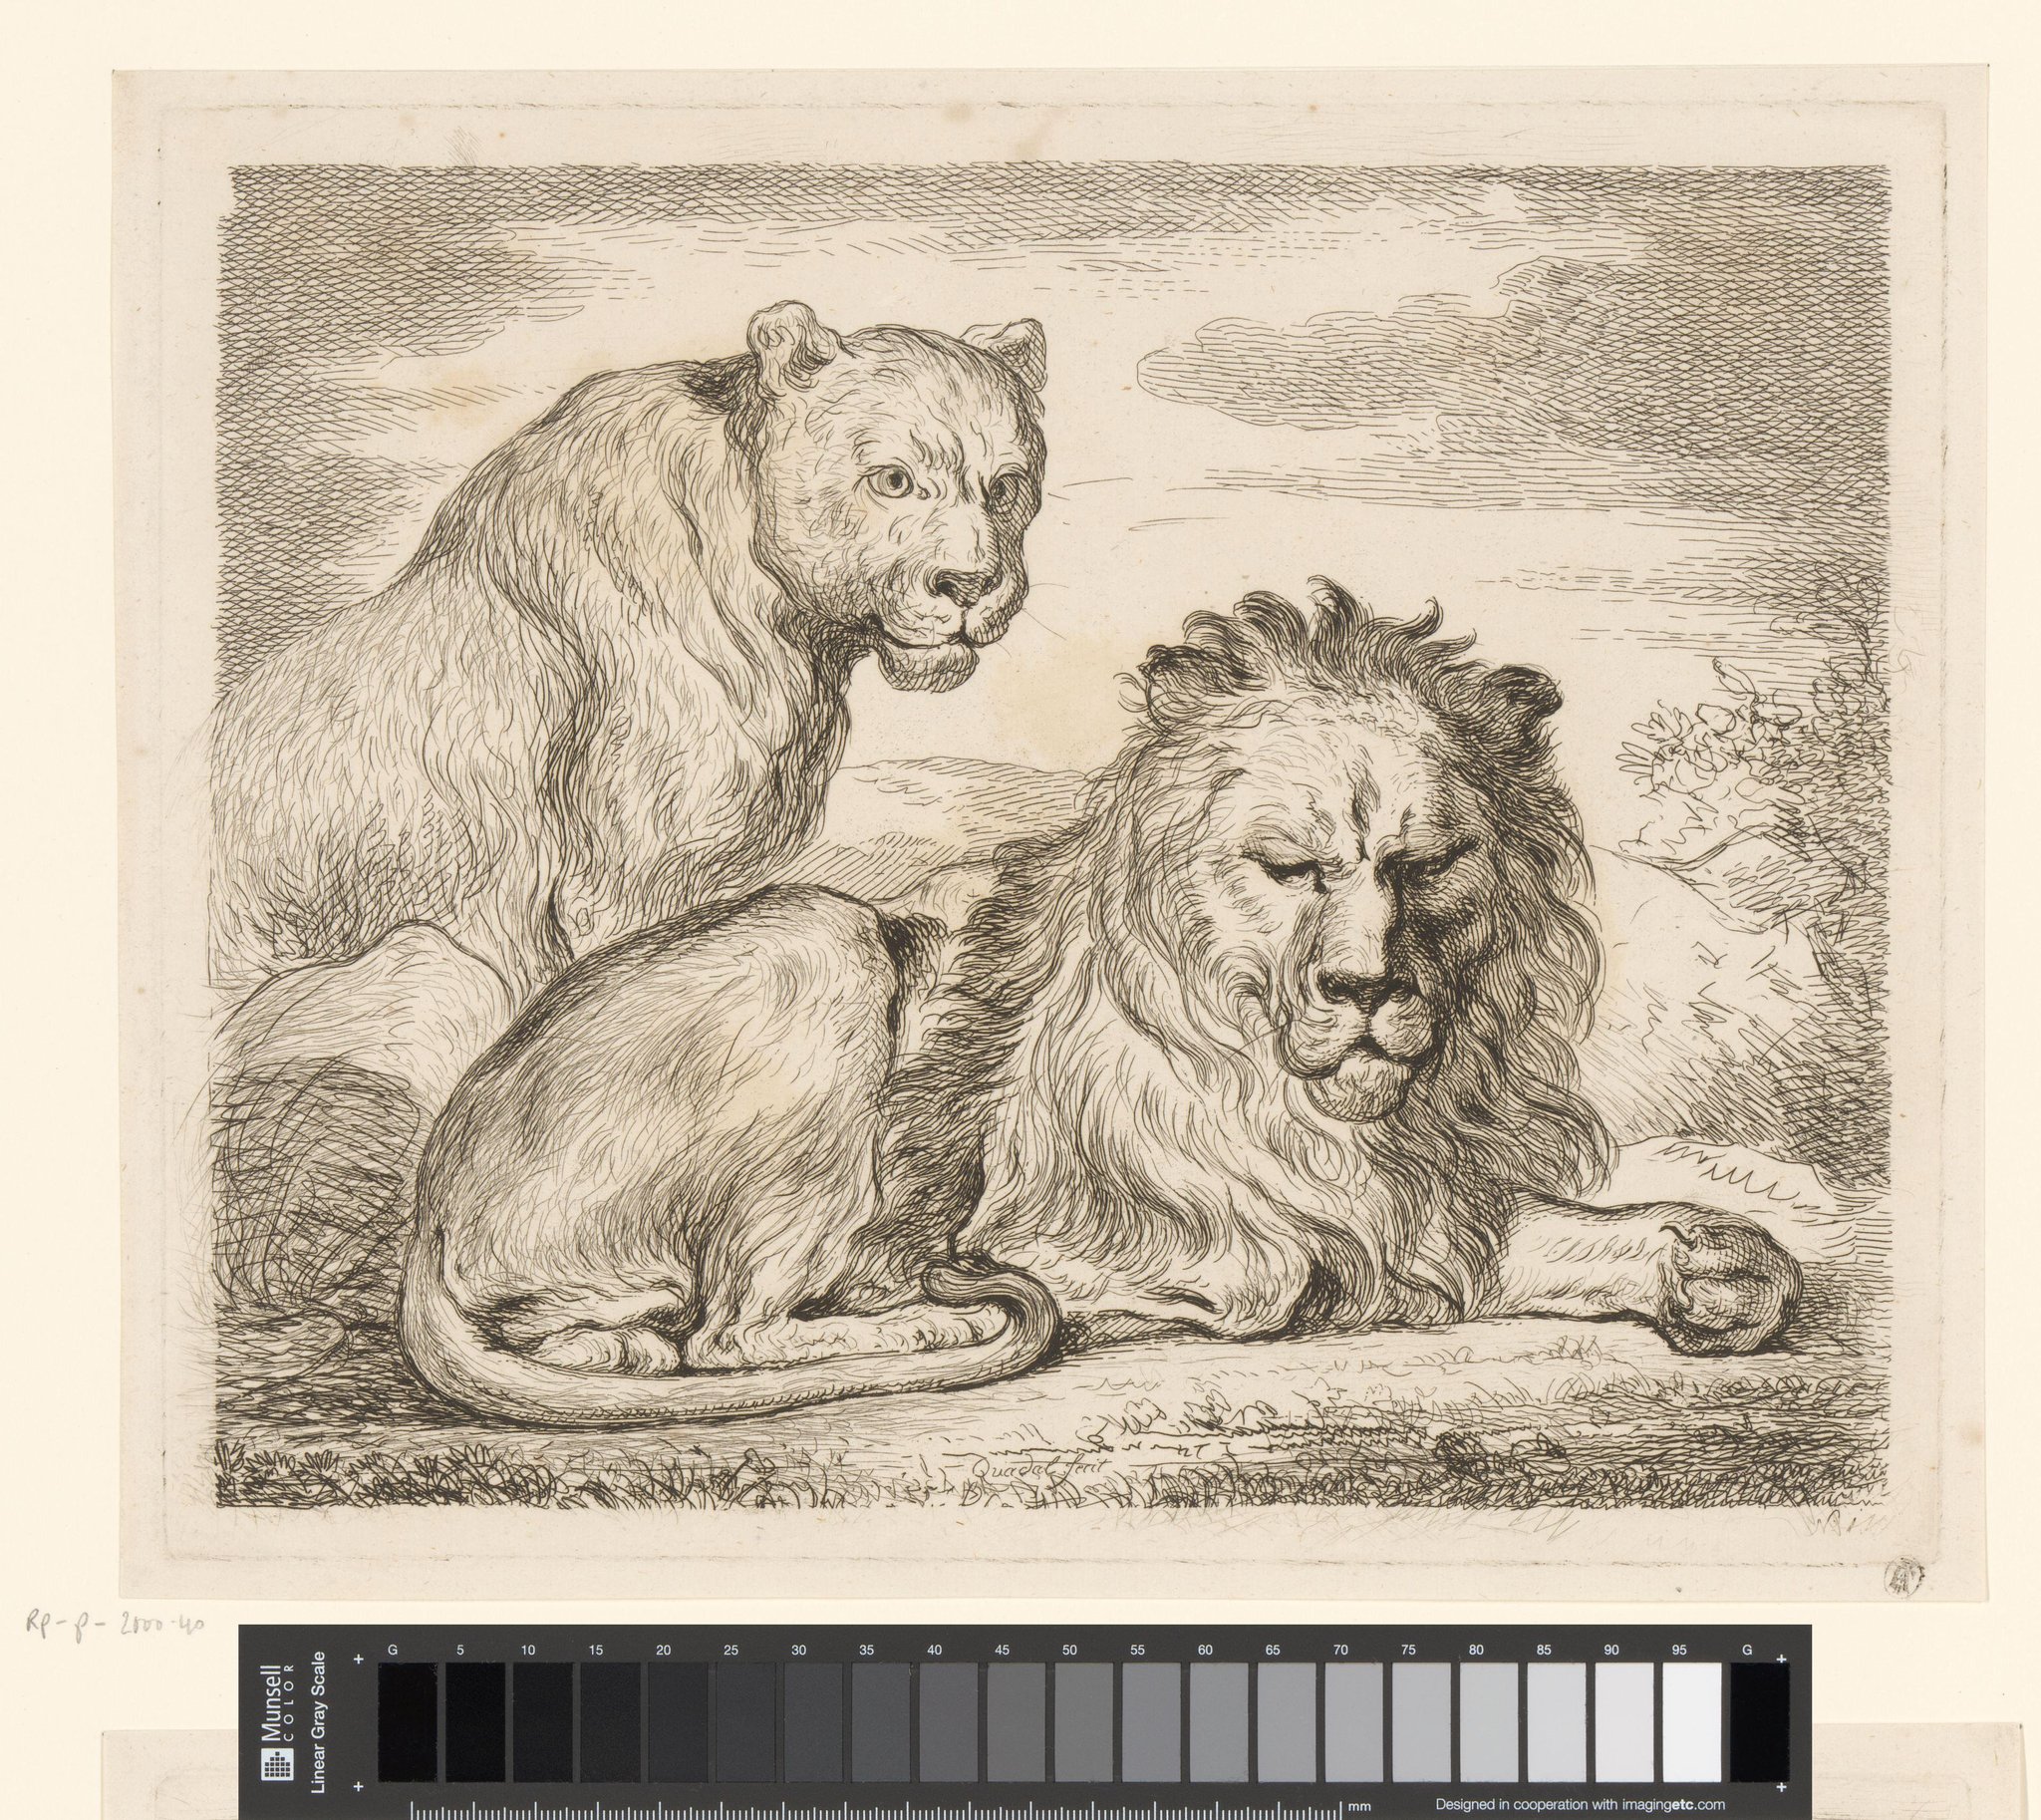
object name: print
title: Leeuw en leeuwin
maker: martin ferdinand quadal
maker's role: print maker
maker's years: 1736-1808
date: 1793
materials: paper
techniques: etching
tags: beasts of prey, predatory animals: lion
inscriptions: collector's mark: Lugt 2760, collector's mark: Lugt 2228, collector's mark: Lugt 971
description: Prent onderdeel van de serie: A variety of Tame and Wild Animals Studies from nature (...). Londen: Quadal, 1793.